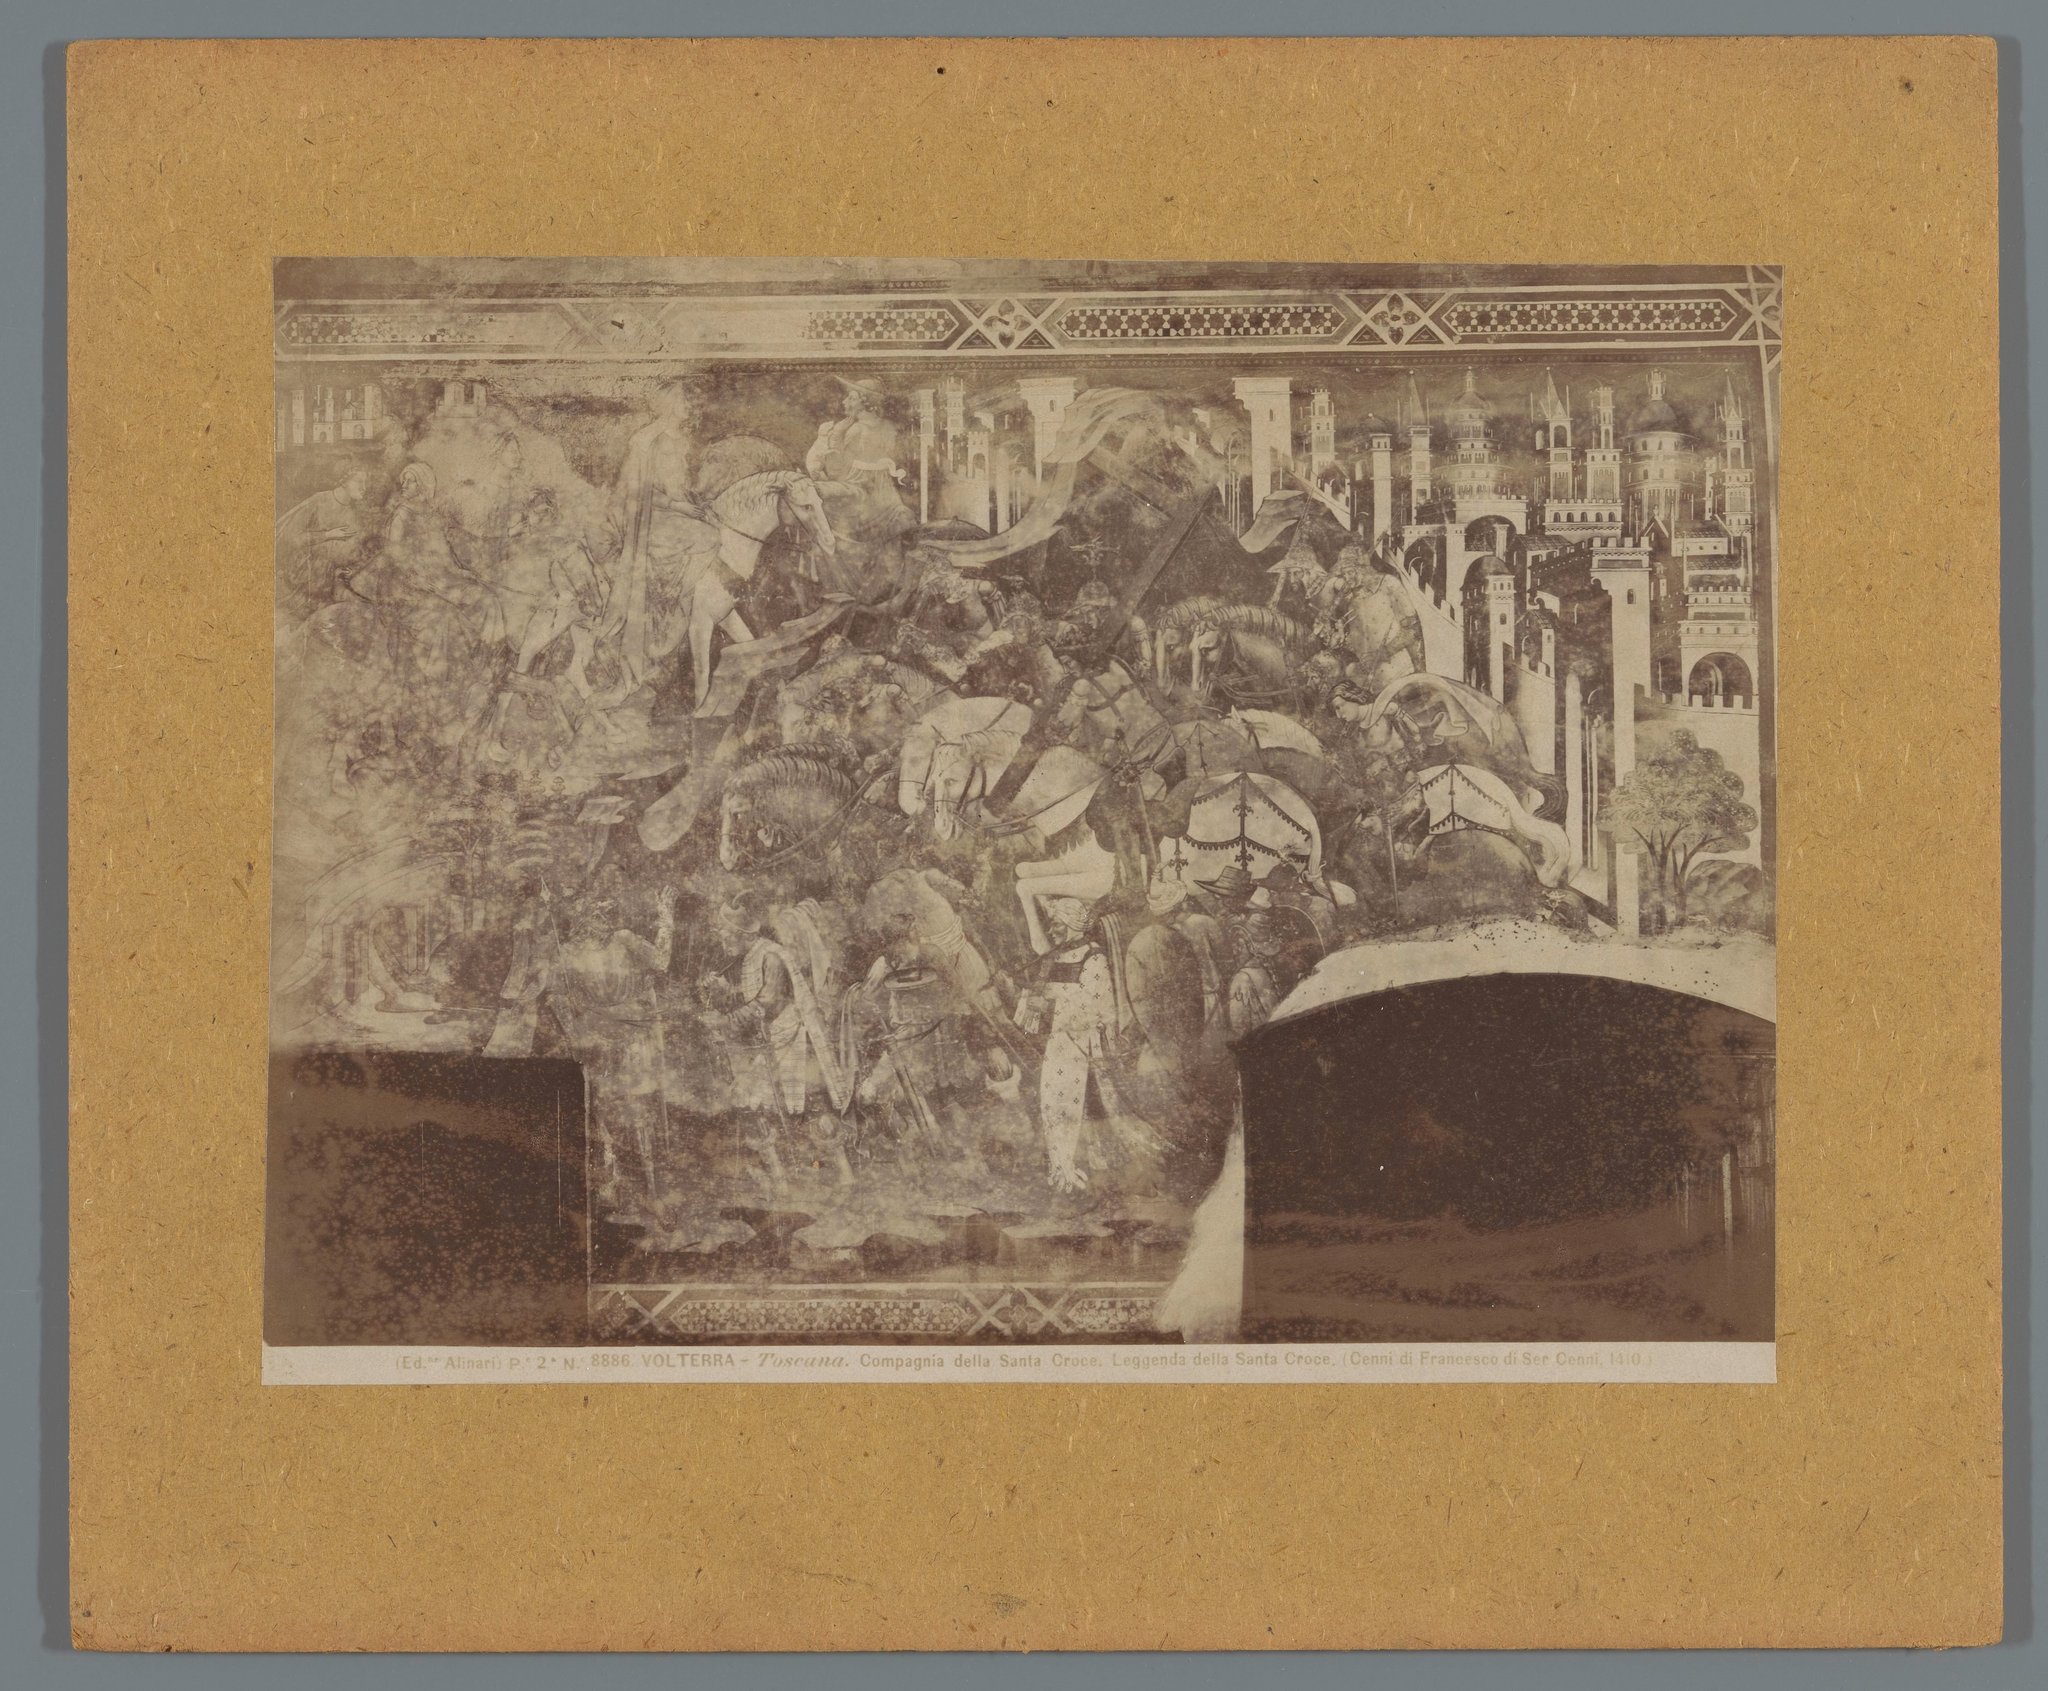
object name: reproduction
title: Fotoreproductie van een fresco door Cenni di Francesco in de Cappella della Croce di Giorno te Volterra, voorstellende de roof van het Heilige Kruis door Khusro II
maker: cenni di francesco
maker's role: painter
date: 1875-1900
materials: cardboard, photographic support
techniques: albumen print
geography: chiesa di san francesco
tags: legend of the true cross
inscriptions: number: ‘P. 2. N. 8886.’, collector's mark: Lugt 3937